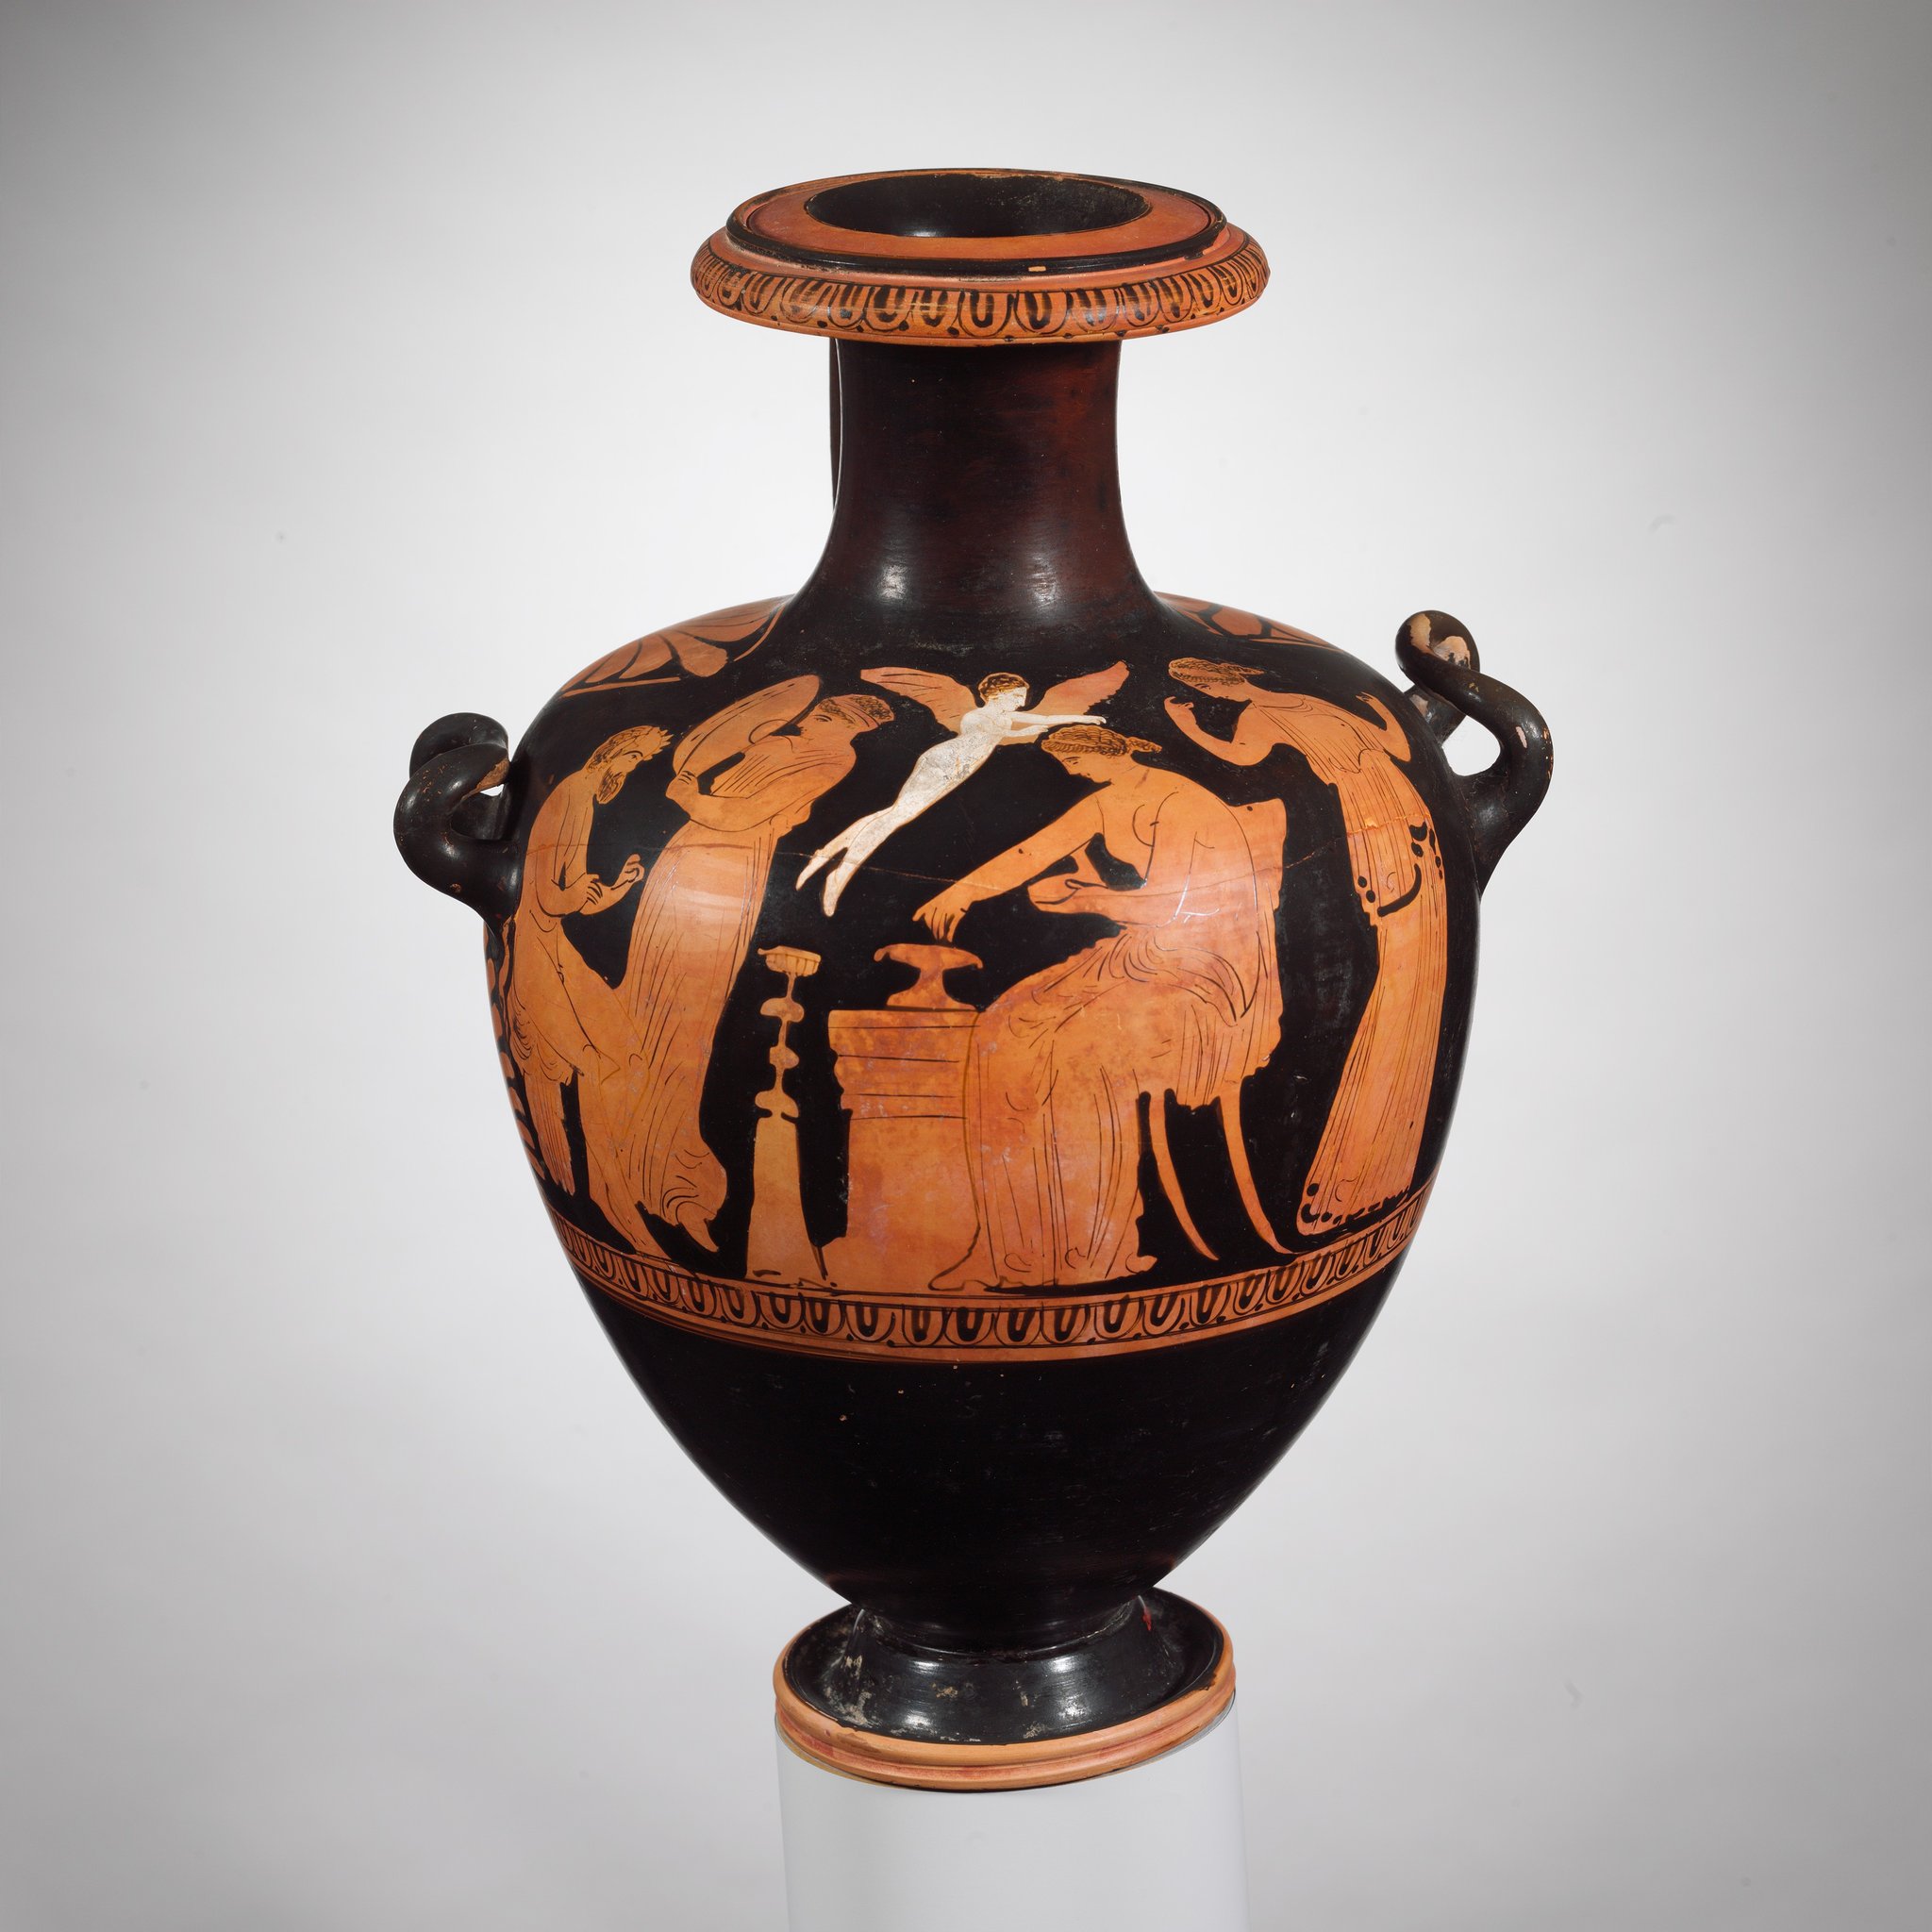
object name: hydria, kalpis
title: Terracotta hydria: kalpis (water jar)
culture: greek, attic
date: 400-301 BCE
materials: terracotta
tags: women,eros,satyrs,incense burners